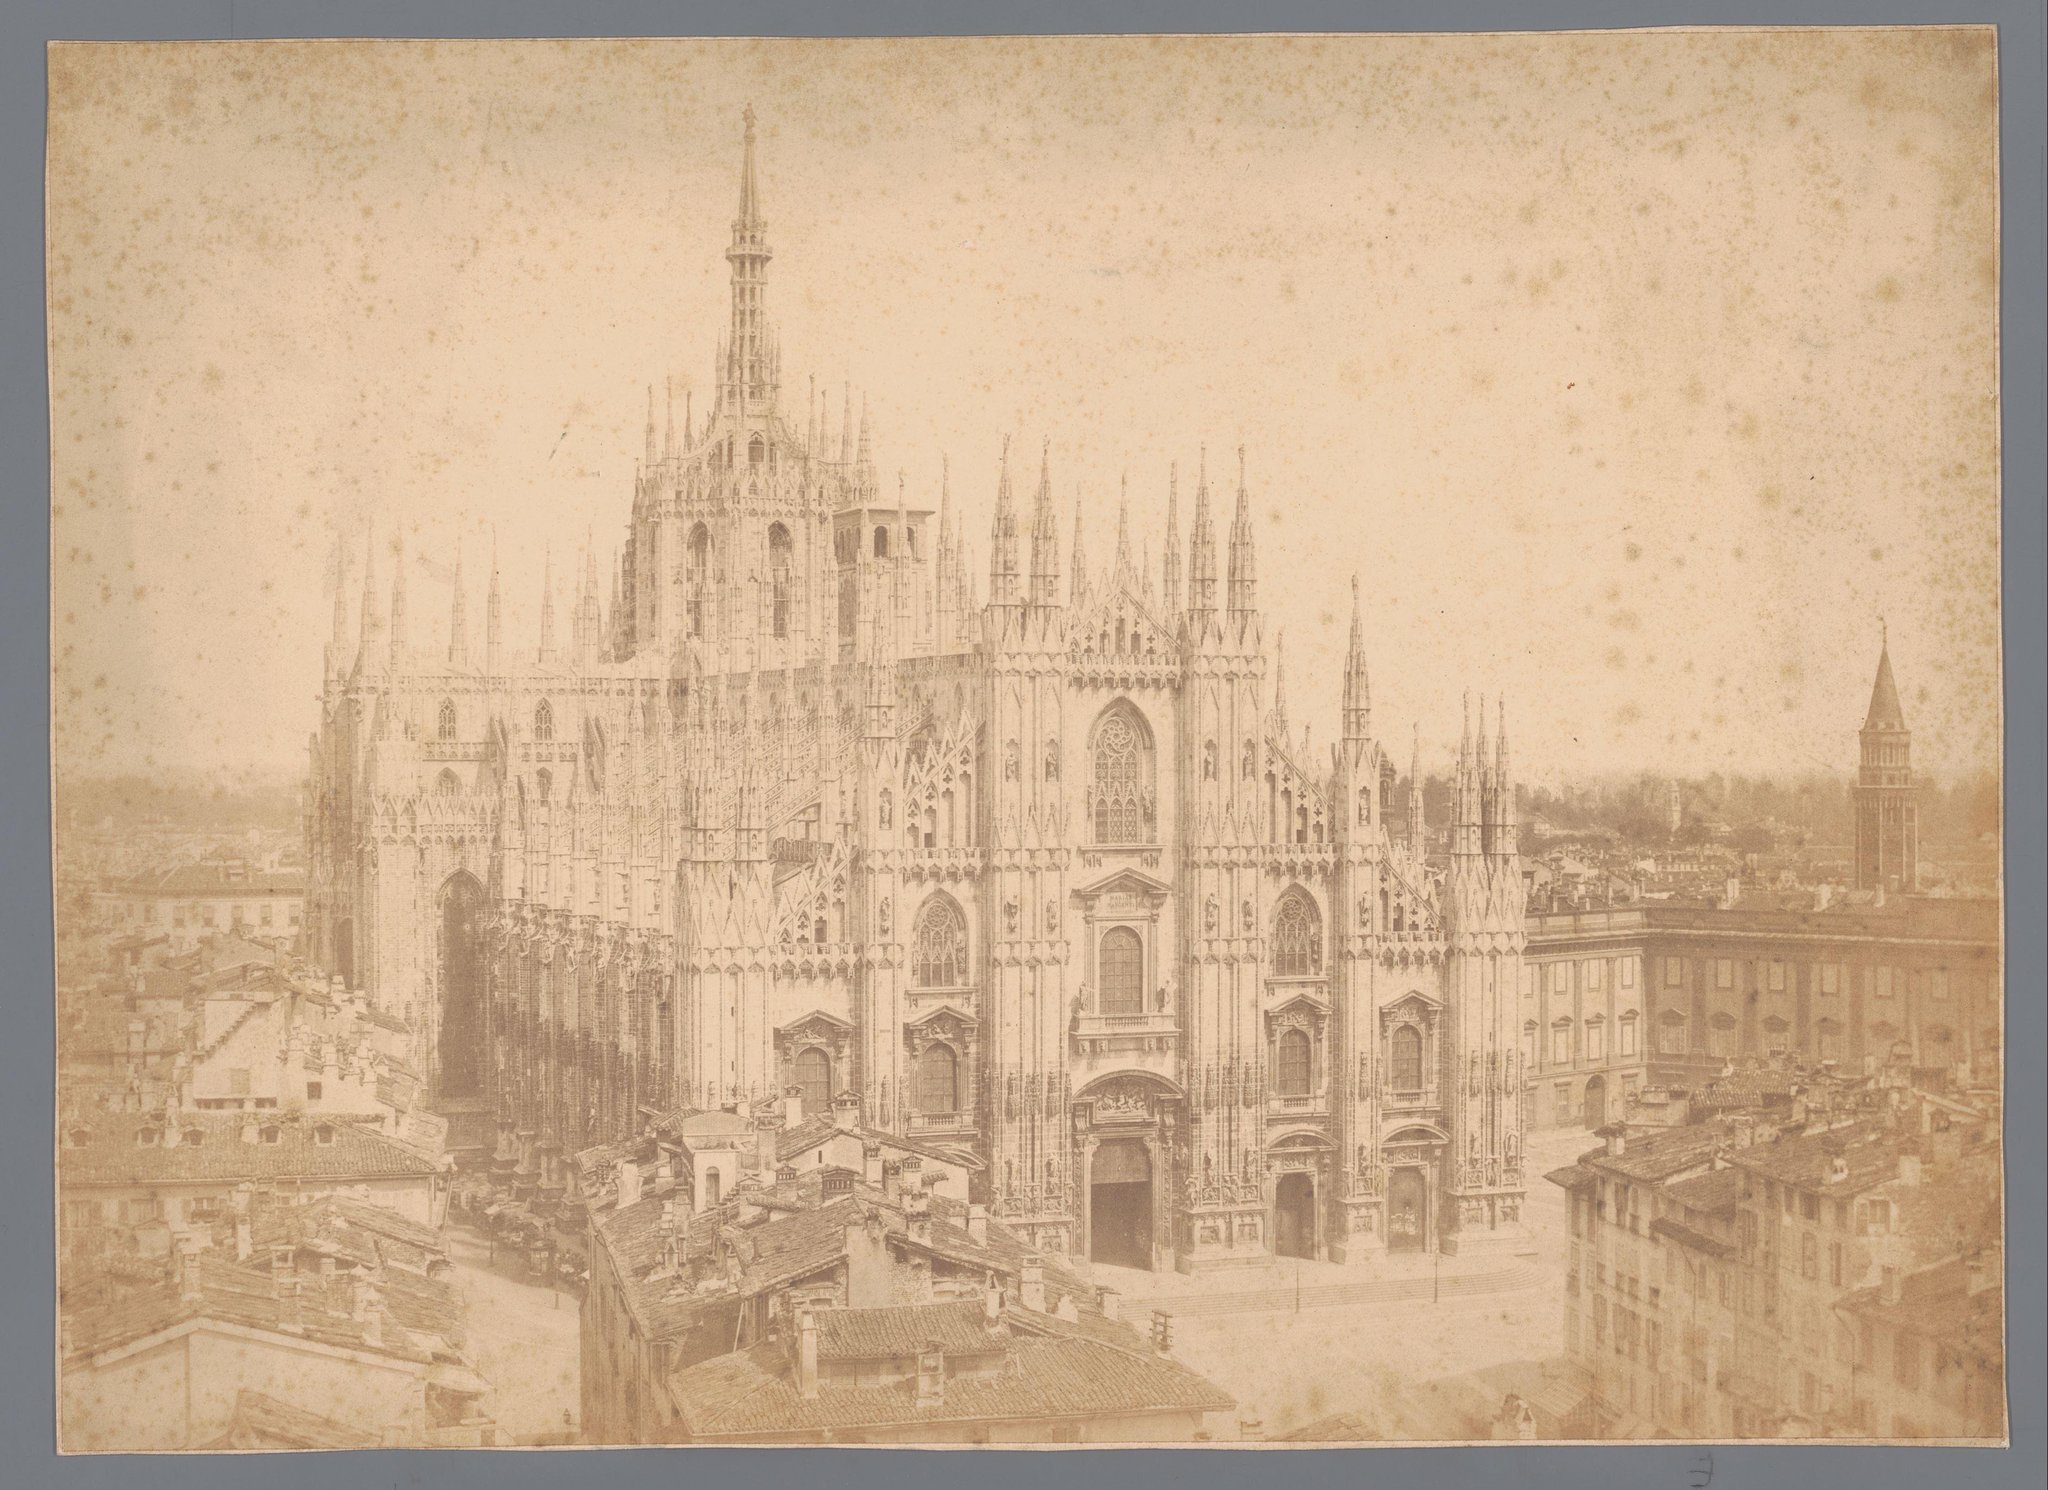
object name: photograph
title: Gezicht op de Dom in Milaan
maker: pompeo pozzi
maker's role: fotograaf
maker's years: 1817-1880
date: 1850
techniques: salted paper print